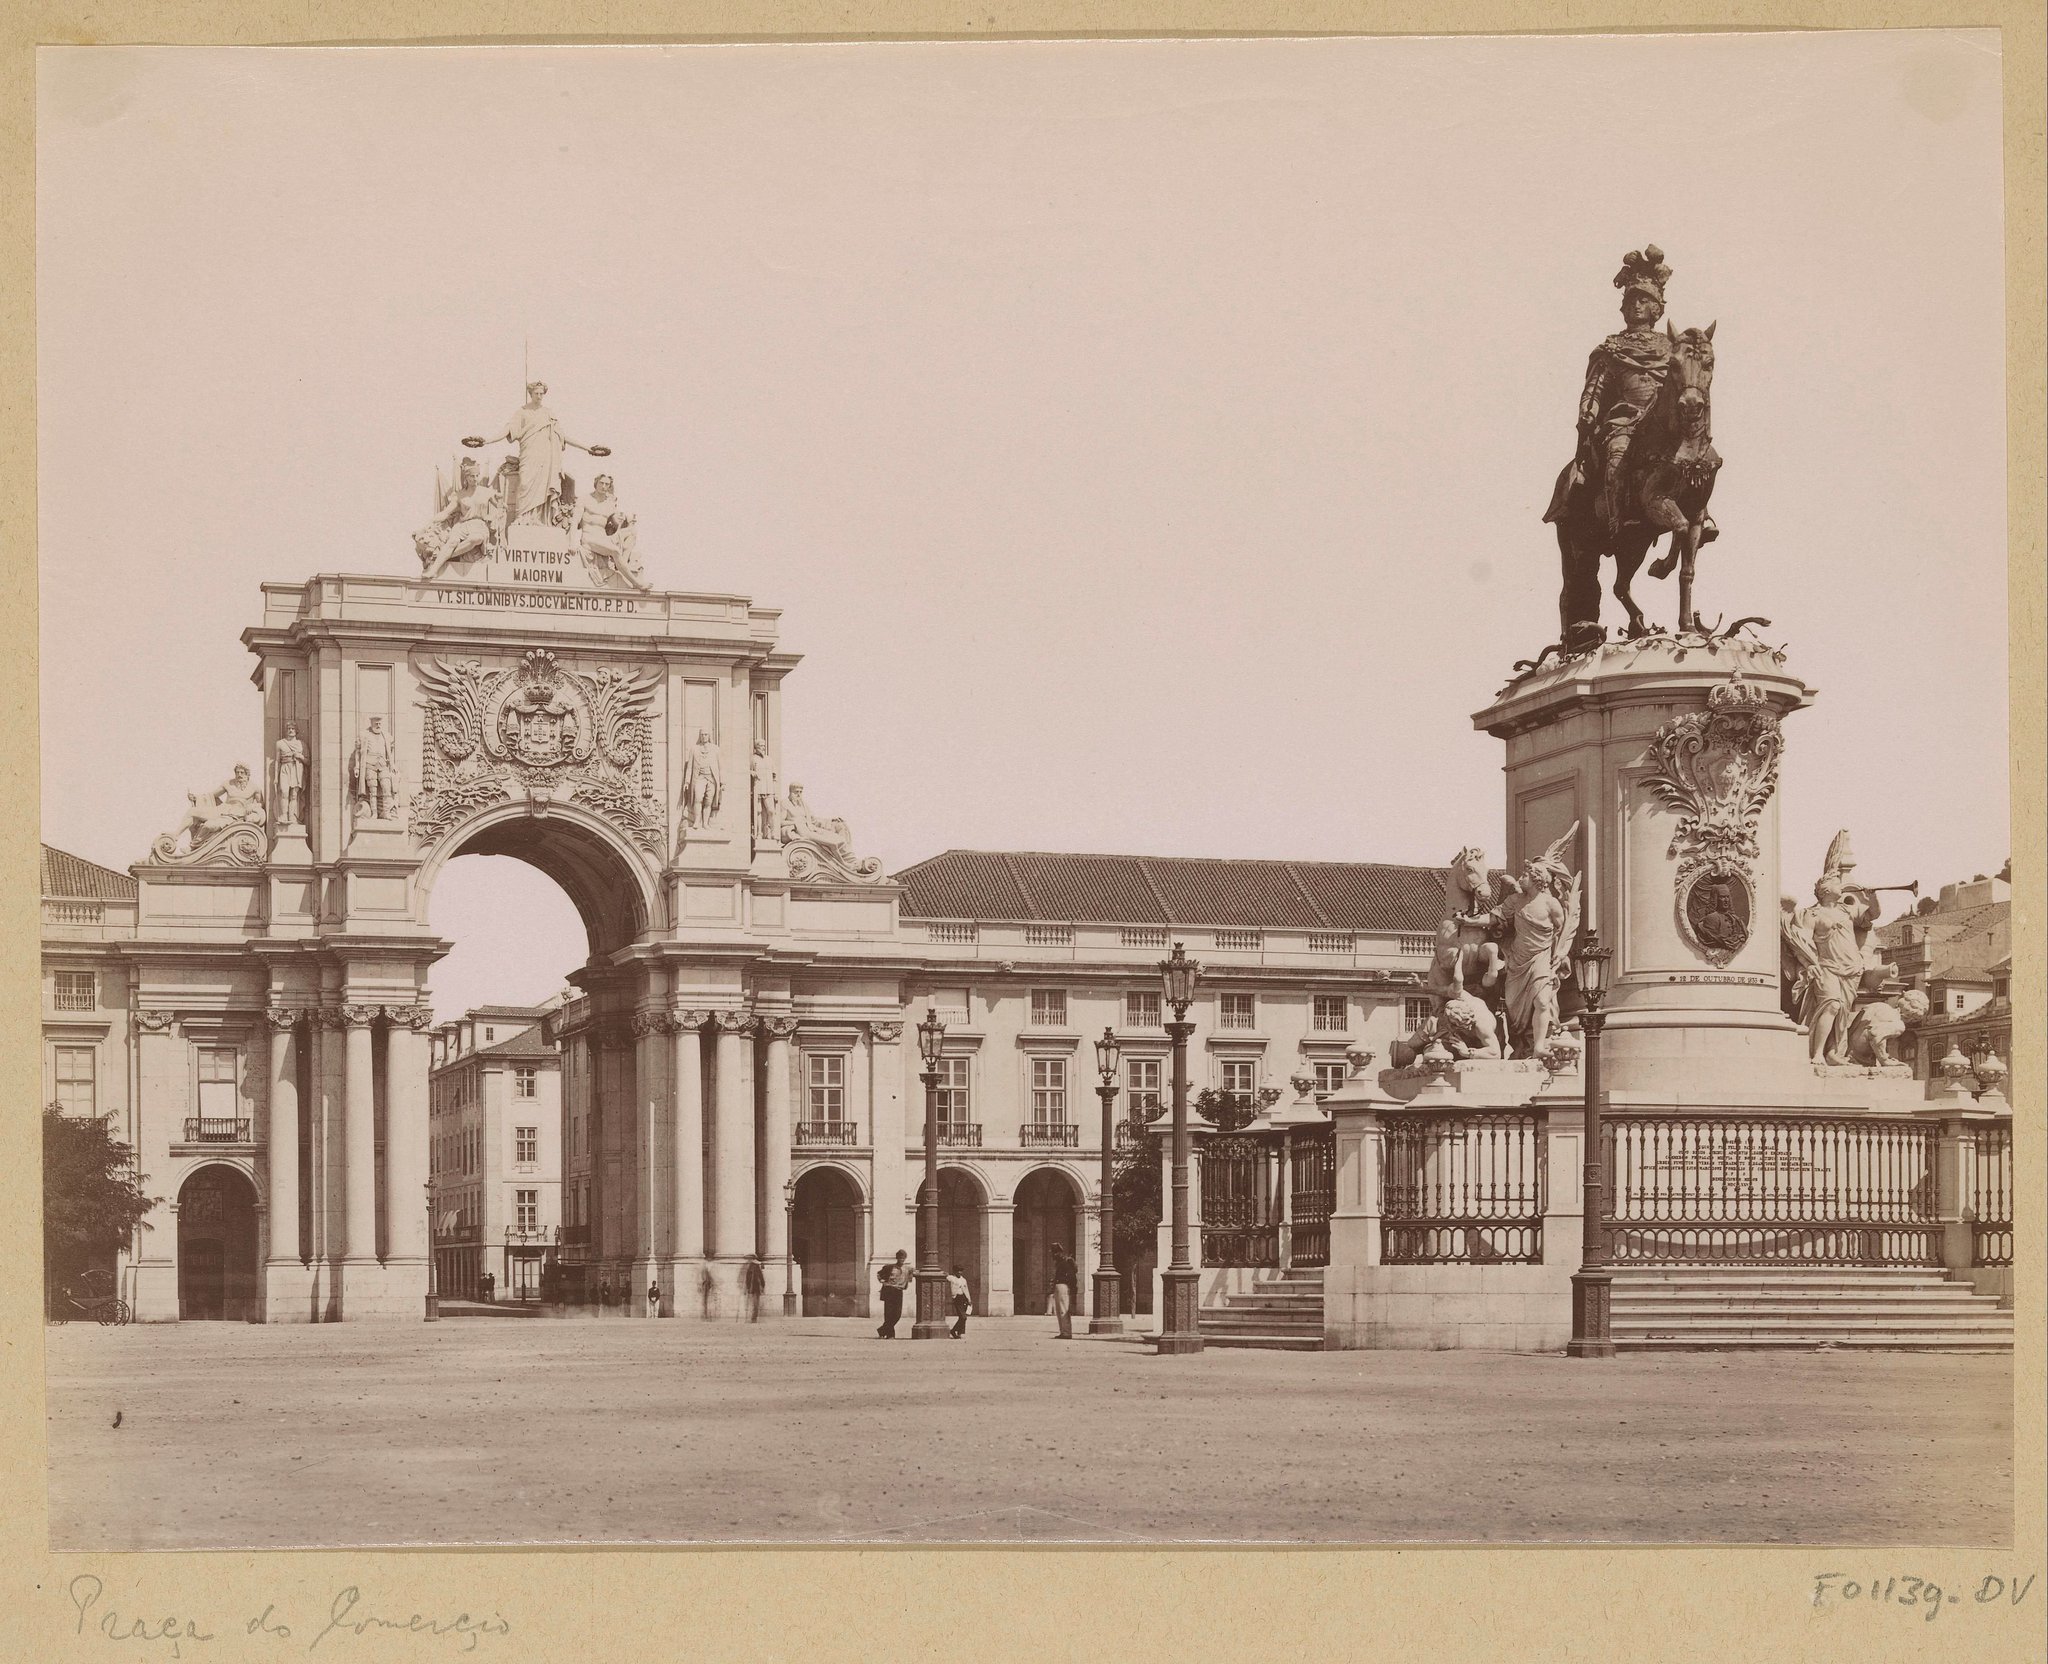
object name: album leaf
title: Gezicht op het Praça do Comércio in Lissabon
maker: Anonymous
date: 1851-1890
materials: paper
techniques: albumen print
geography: lisbon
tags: square, place, circus, etc.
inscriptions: inscription: ‘Praça do Comerçis’